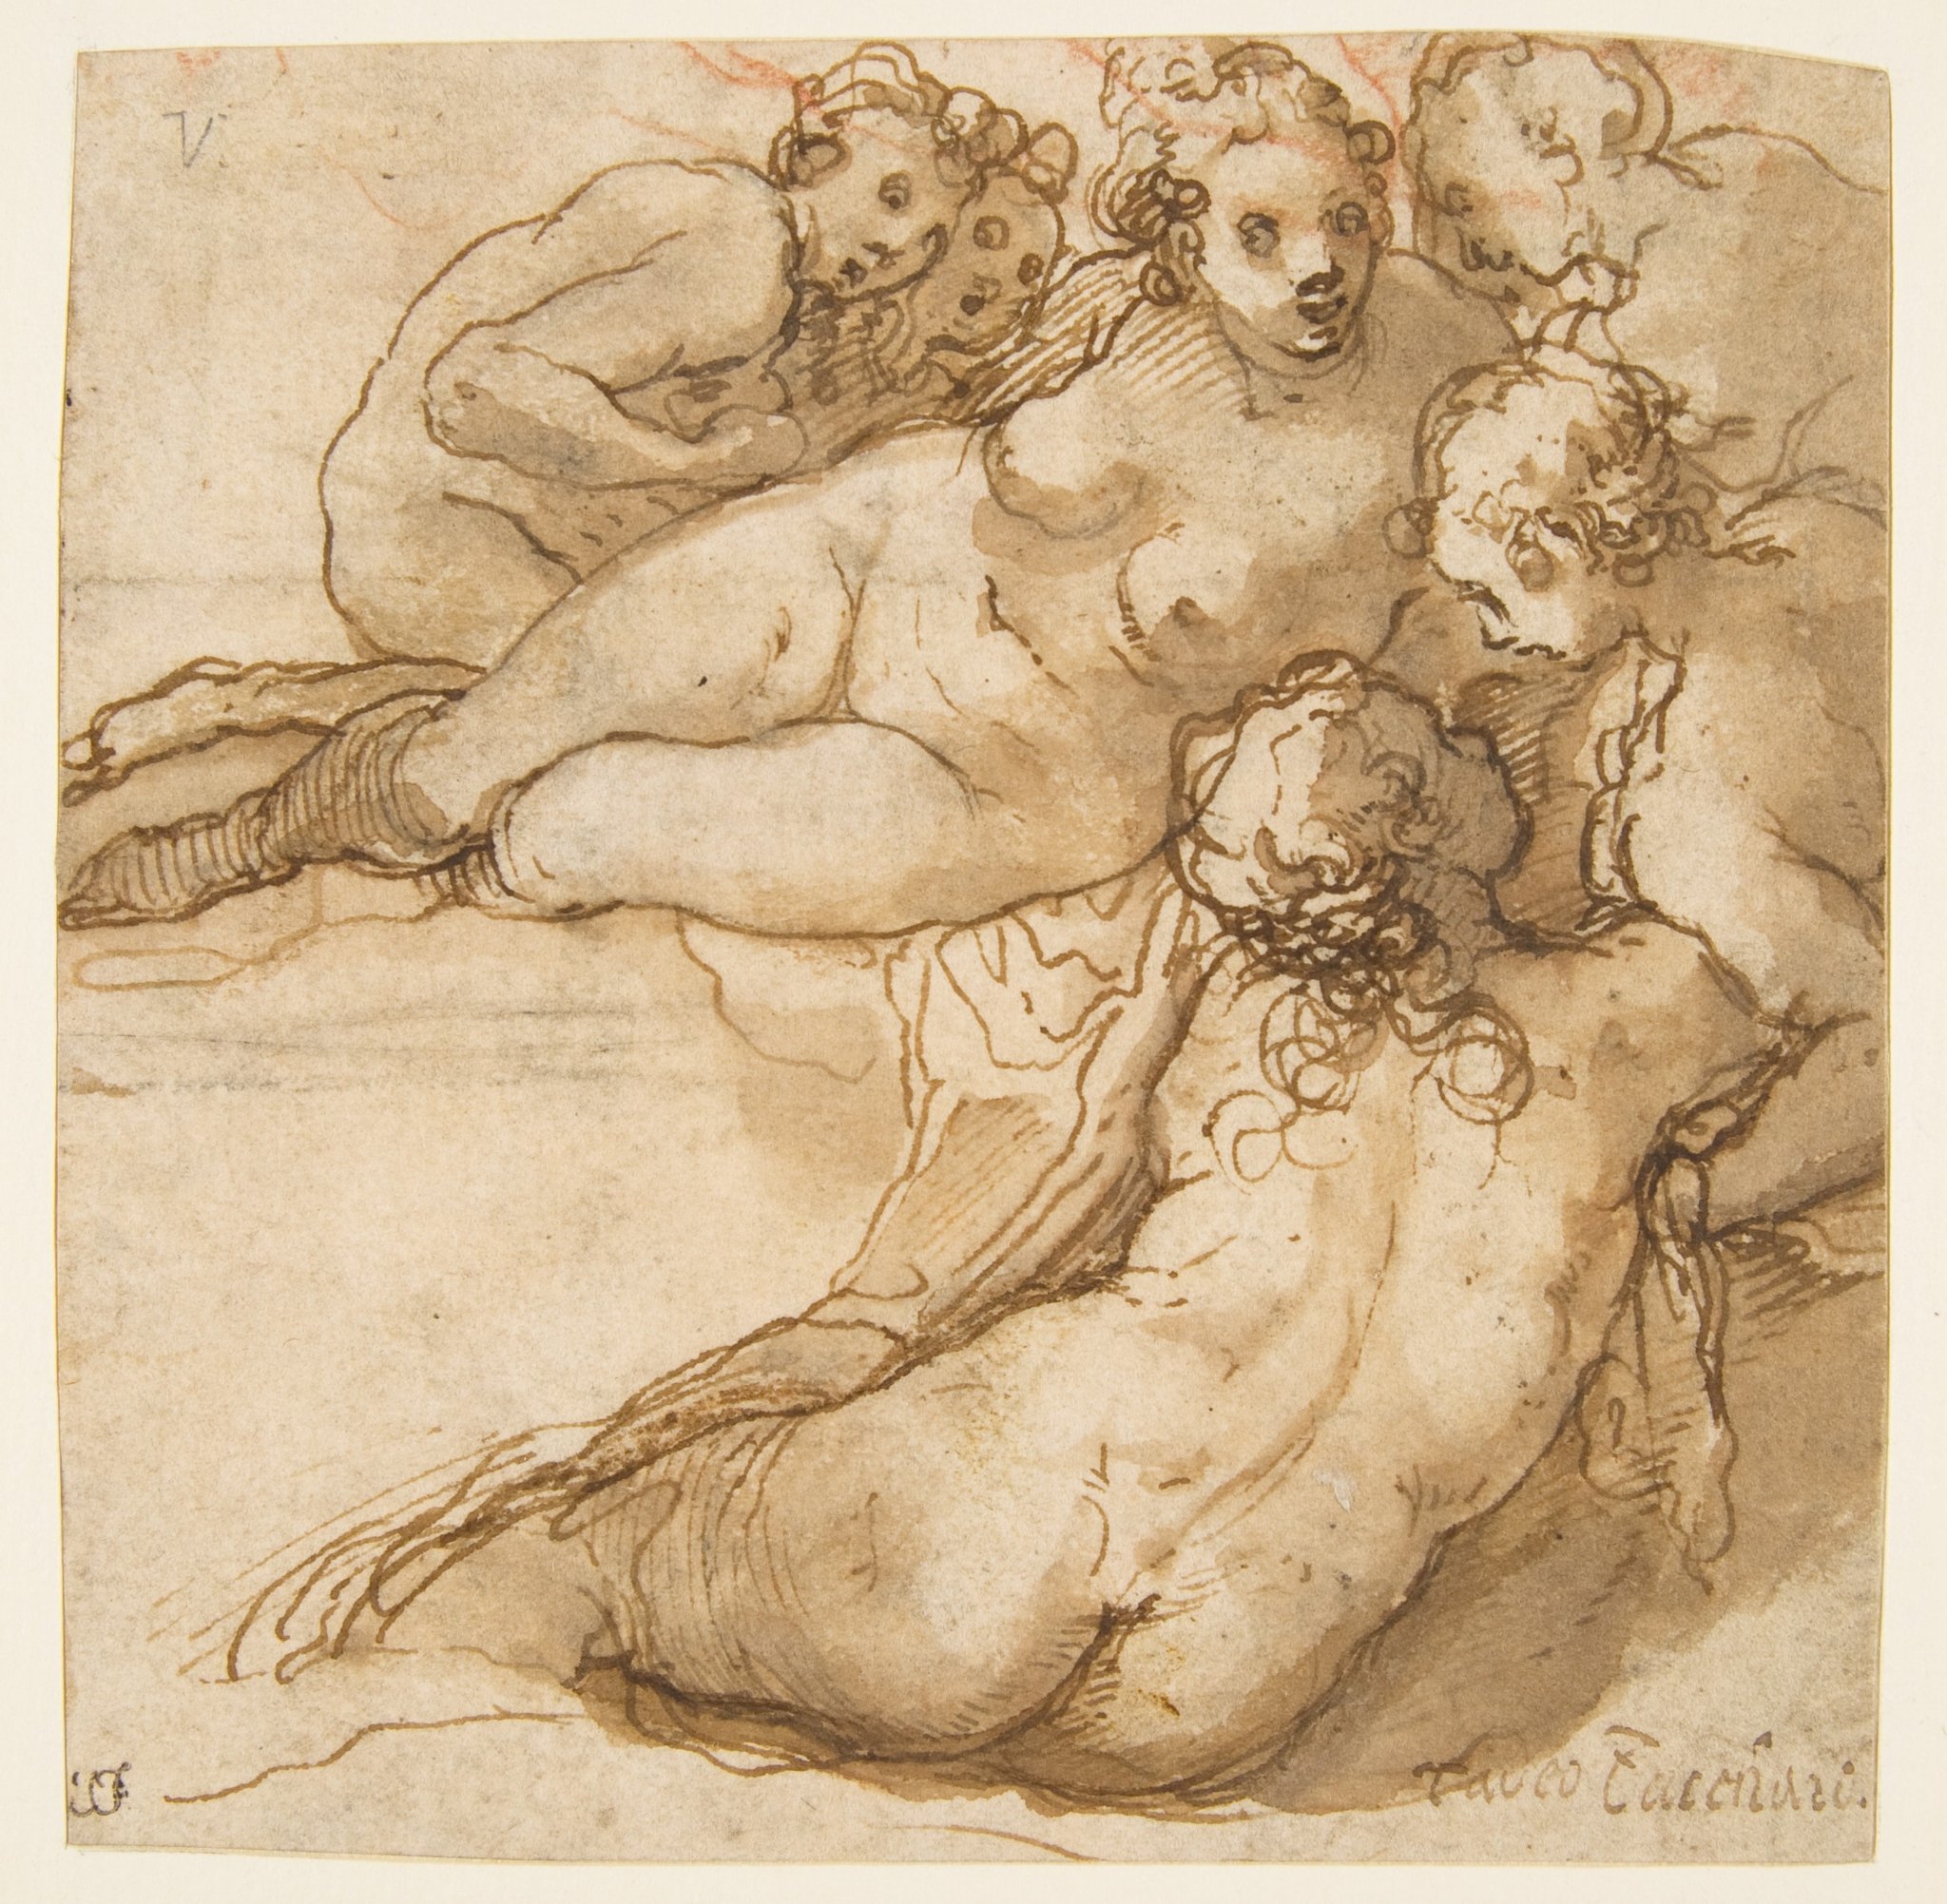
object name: drawing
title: Group of Six Reclining Nude Women (Nymphs Bathing) (recto); Sketch of a Leg (verso)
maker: taddeo zuccaro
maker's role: artist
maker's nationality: italian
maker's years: 1529-1566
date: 1529-1566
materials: chalk, ink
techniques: brush, pen, wash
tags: female nudes,nymphs,bathing